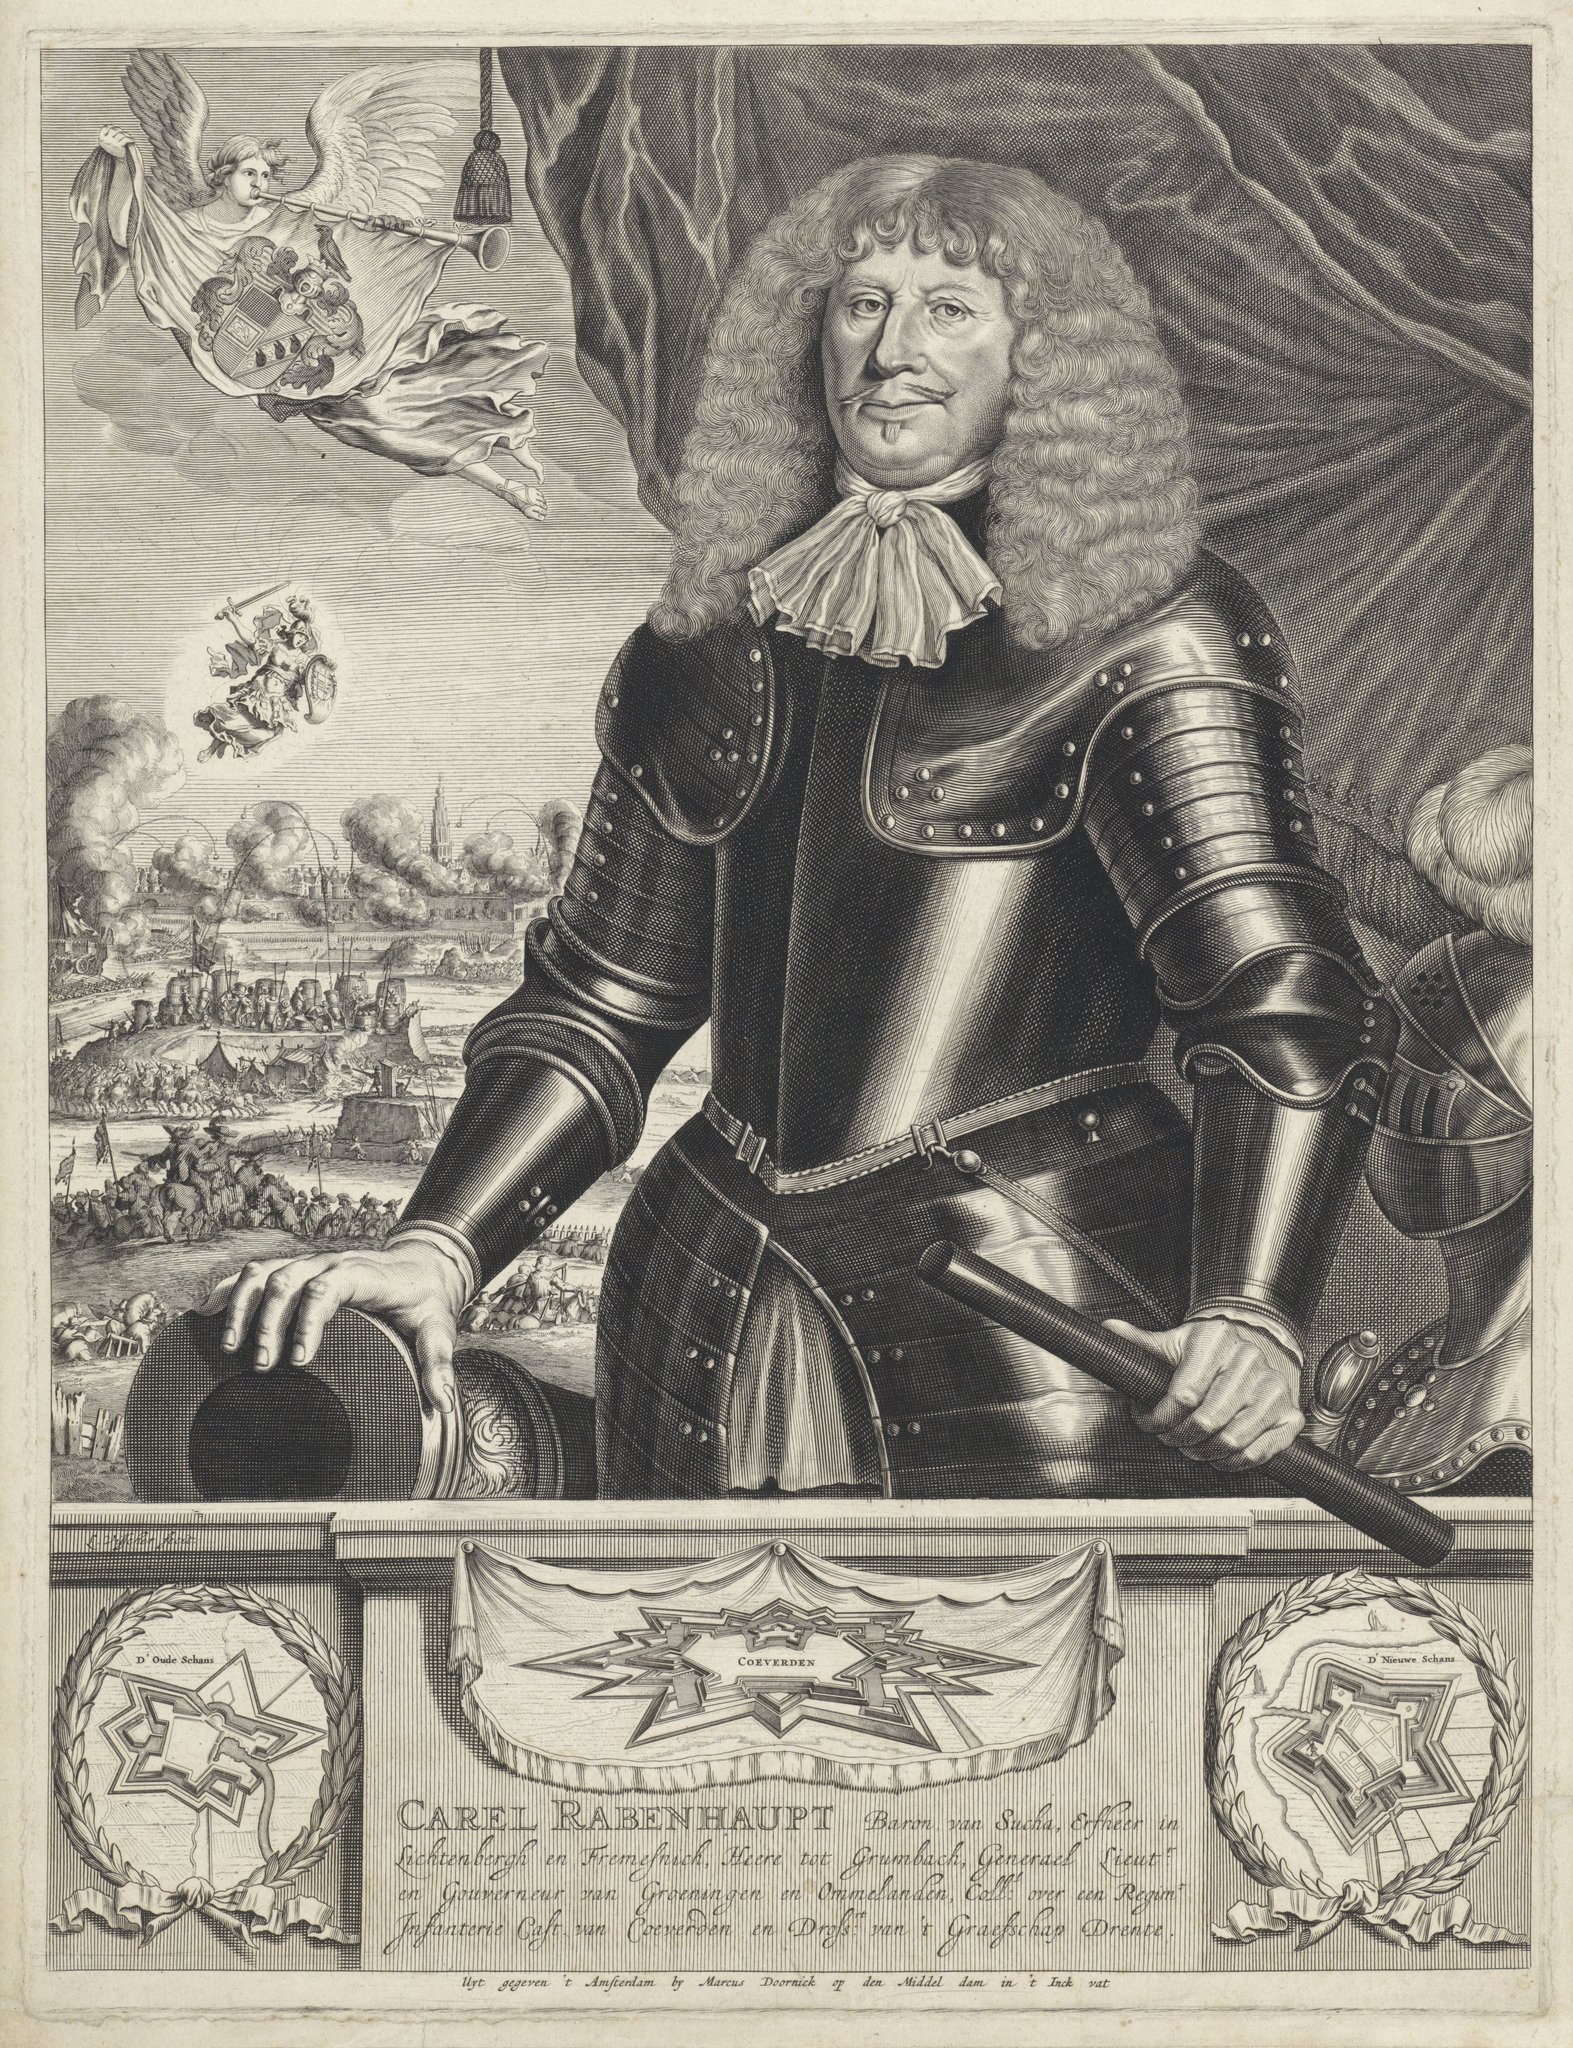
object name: print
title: Portret van Karl von Rabenhaupt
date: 1659-1702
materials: paper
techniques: engraving, etching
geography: amsterdam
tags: 'trionfo della fama', 'triumphus famae'; 'carro della fama' (ripa), armour, firearms: cannon, (military) attack, permanent fortifications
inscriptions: collector's mark: Lugt 2228, collector's mark: Lugt 2773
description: Portret van luitenant-generaal Karl Rabenhaupt, baron de Sucha, erfheer van Lichtenberg en Fremesnich, heer tot Grumbach. Rabenhaupt speelde een hoofdrol bij de verdediging van Groningen en de inname van Coevorden (1672). Linksachter een belegerde stad (mogelijk Groningen). Onder het portret kaarten met 'D'Oude Schans' 'Niewer Schans' en 'Coeverden'. In de marge zijn naam en titels.